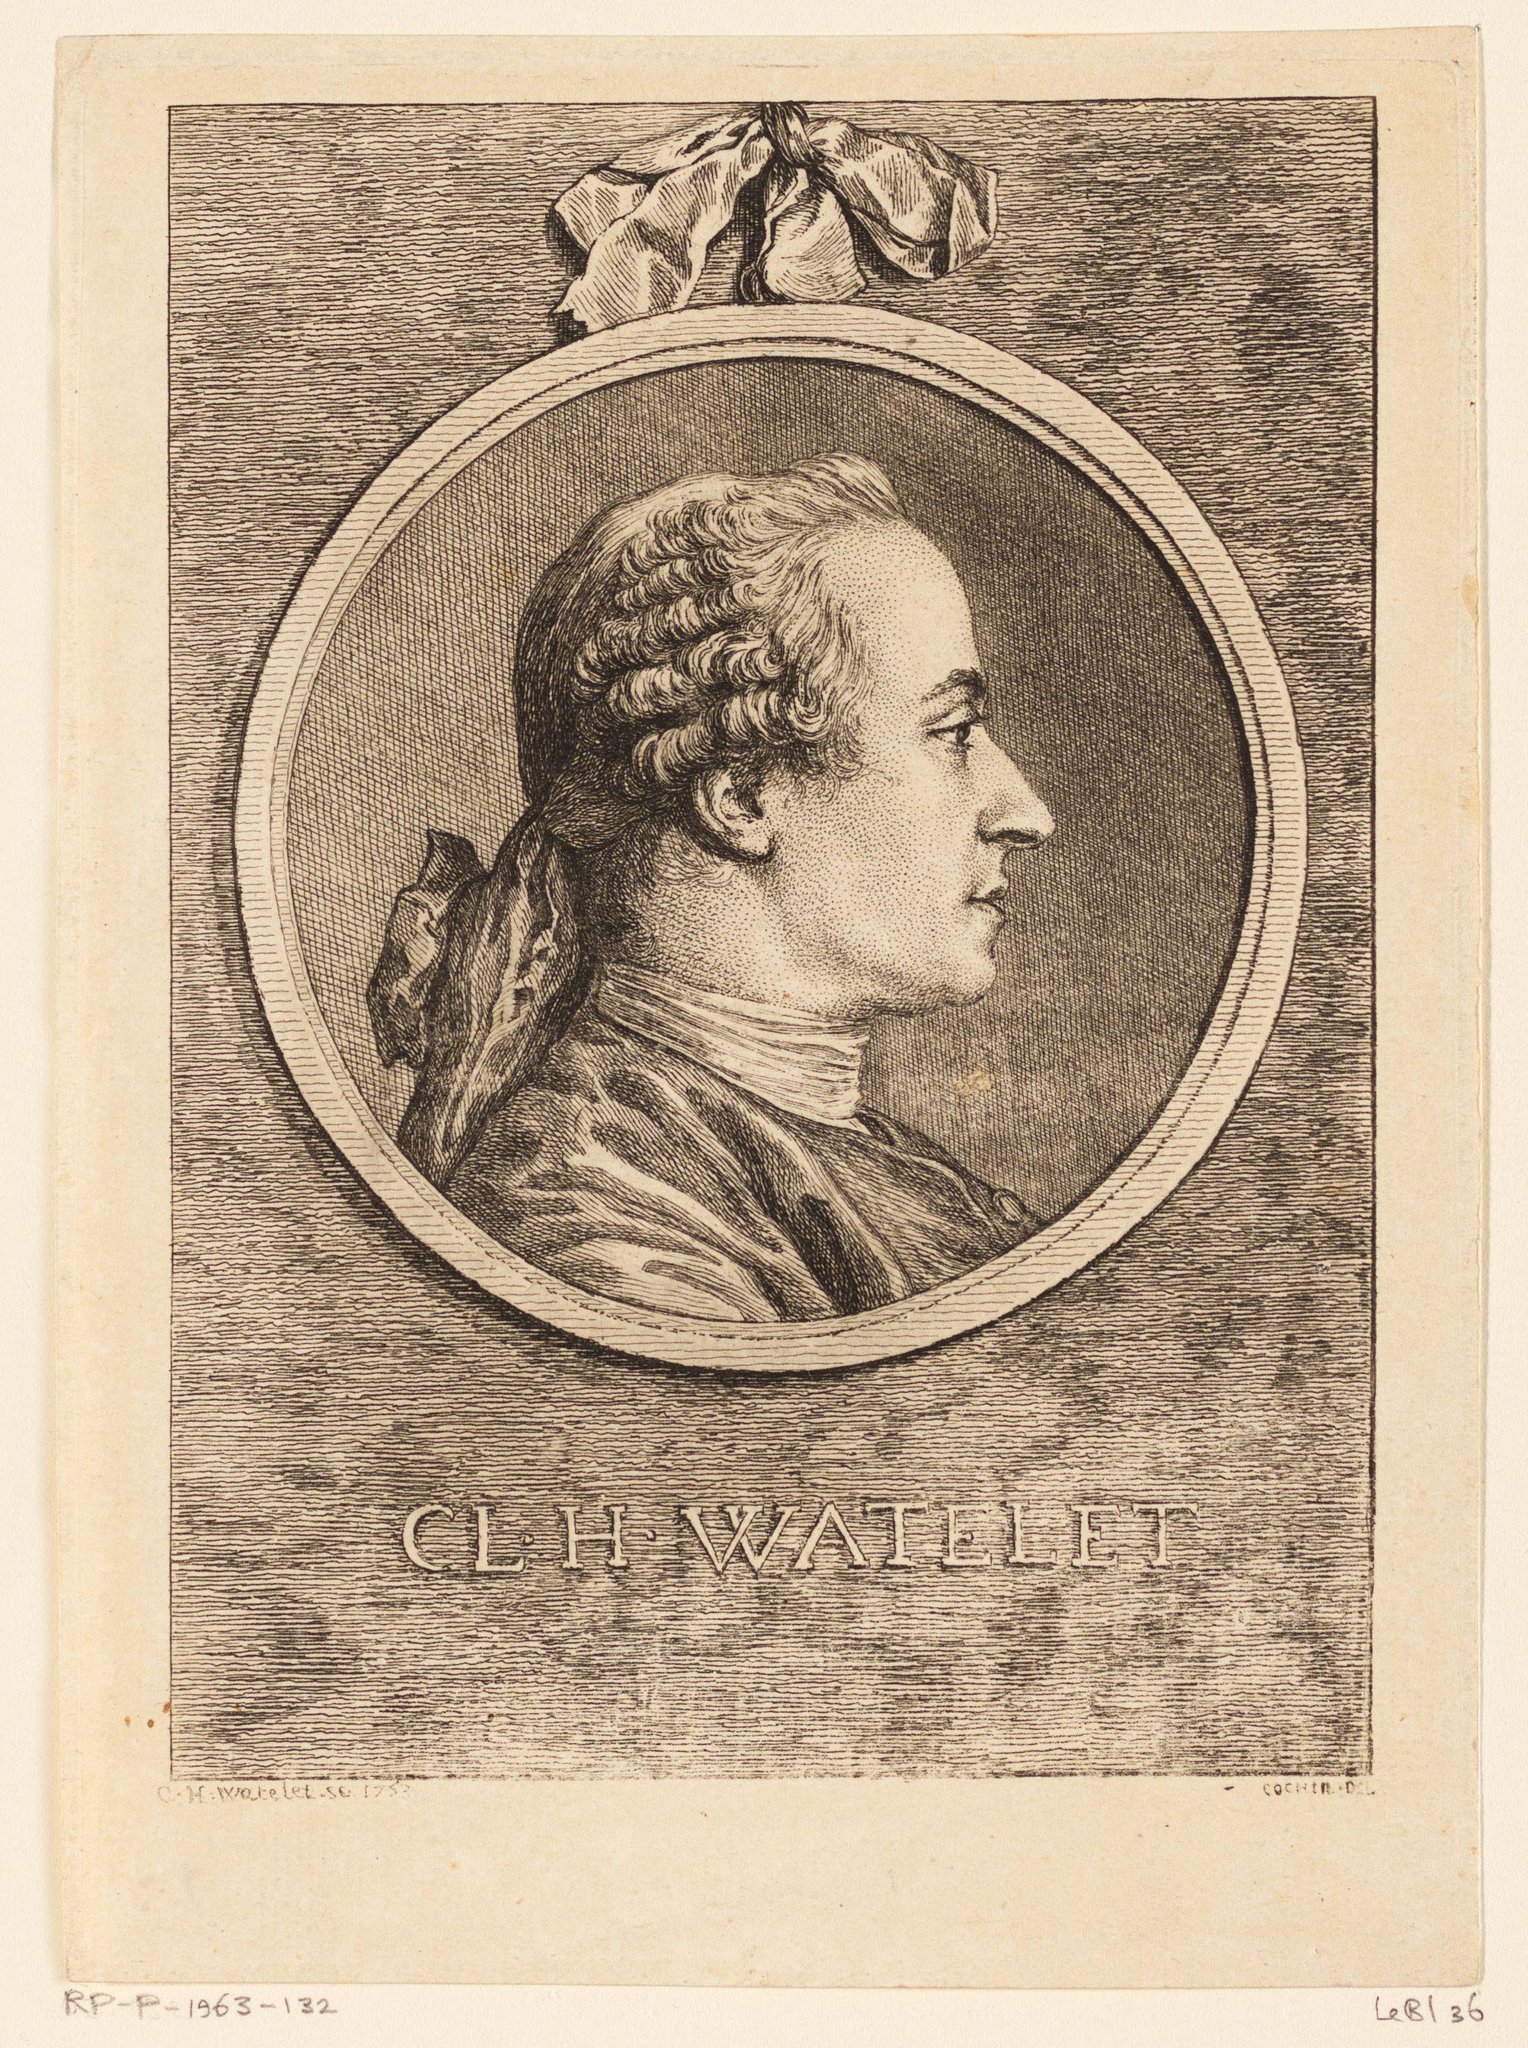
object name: print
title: Zelfportret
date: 1753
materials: paper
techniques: etching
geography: france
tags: paris, print maker, claude henri watelet, historical persons, adult man (+ sideview, profile), portrait, self-portrait of artist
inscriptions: collector's mark: Lugt 2228, collector's mark: Lugt 2760